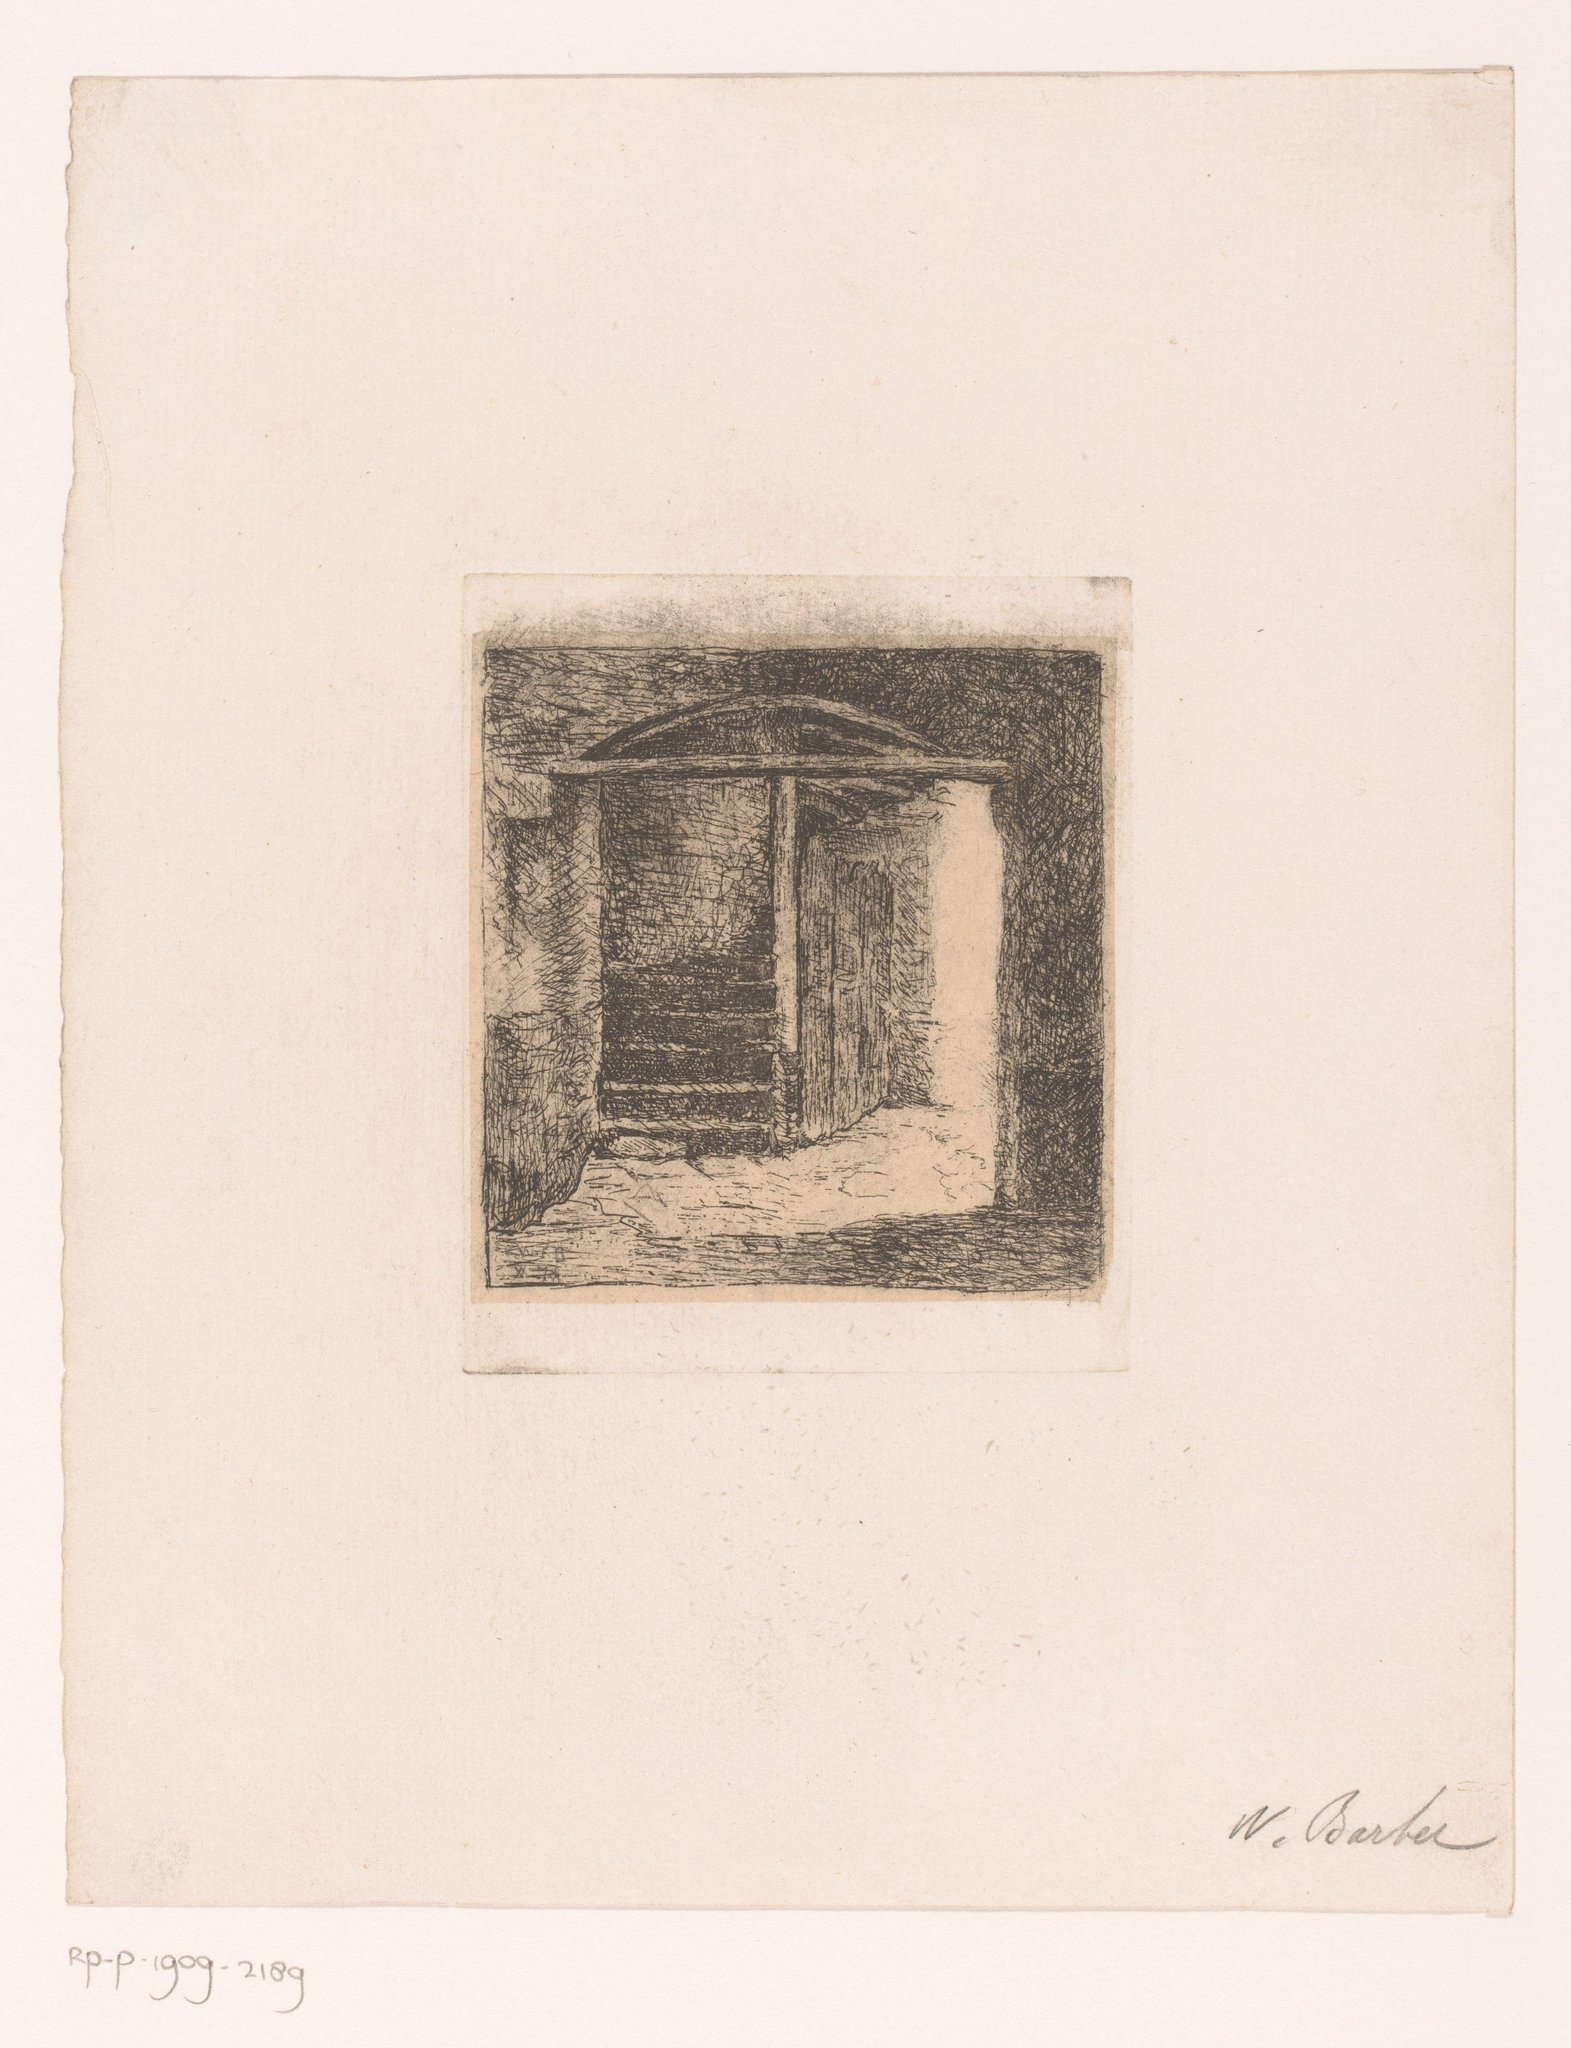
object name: print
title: Interieur met een trap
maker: w.f. barber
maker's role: print maker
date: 1850-1909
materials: paper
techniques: etching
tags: interior of the house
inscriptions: collector's mark: Lugt 2228, annotation: ‘W. Barker’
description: Sterfdatum kunstenaar onbekend. Derhalve is voor bepaling van de rechten van dit object de verwervingsdatum aangehouden.